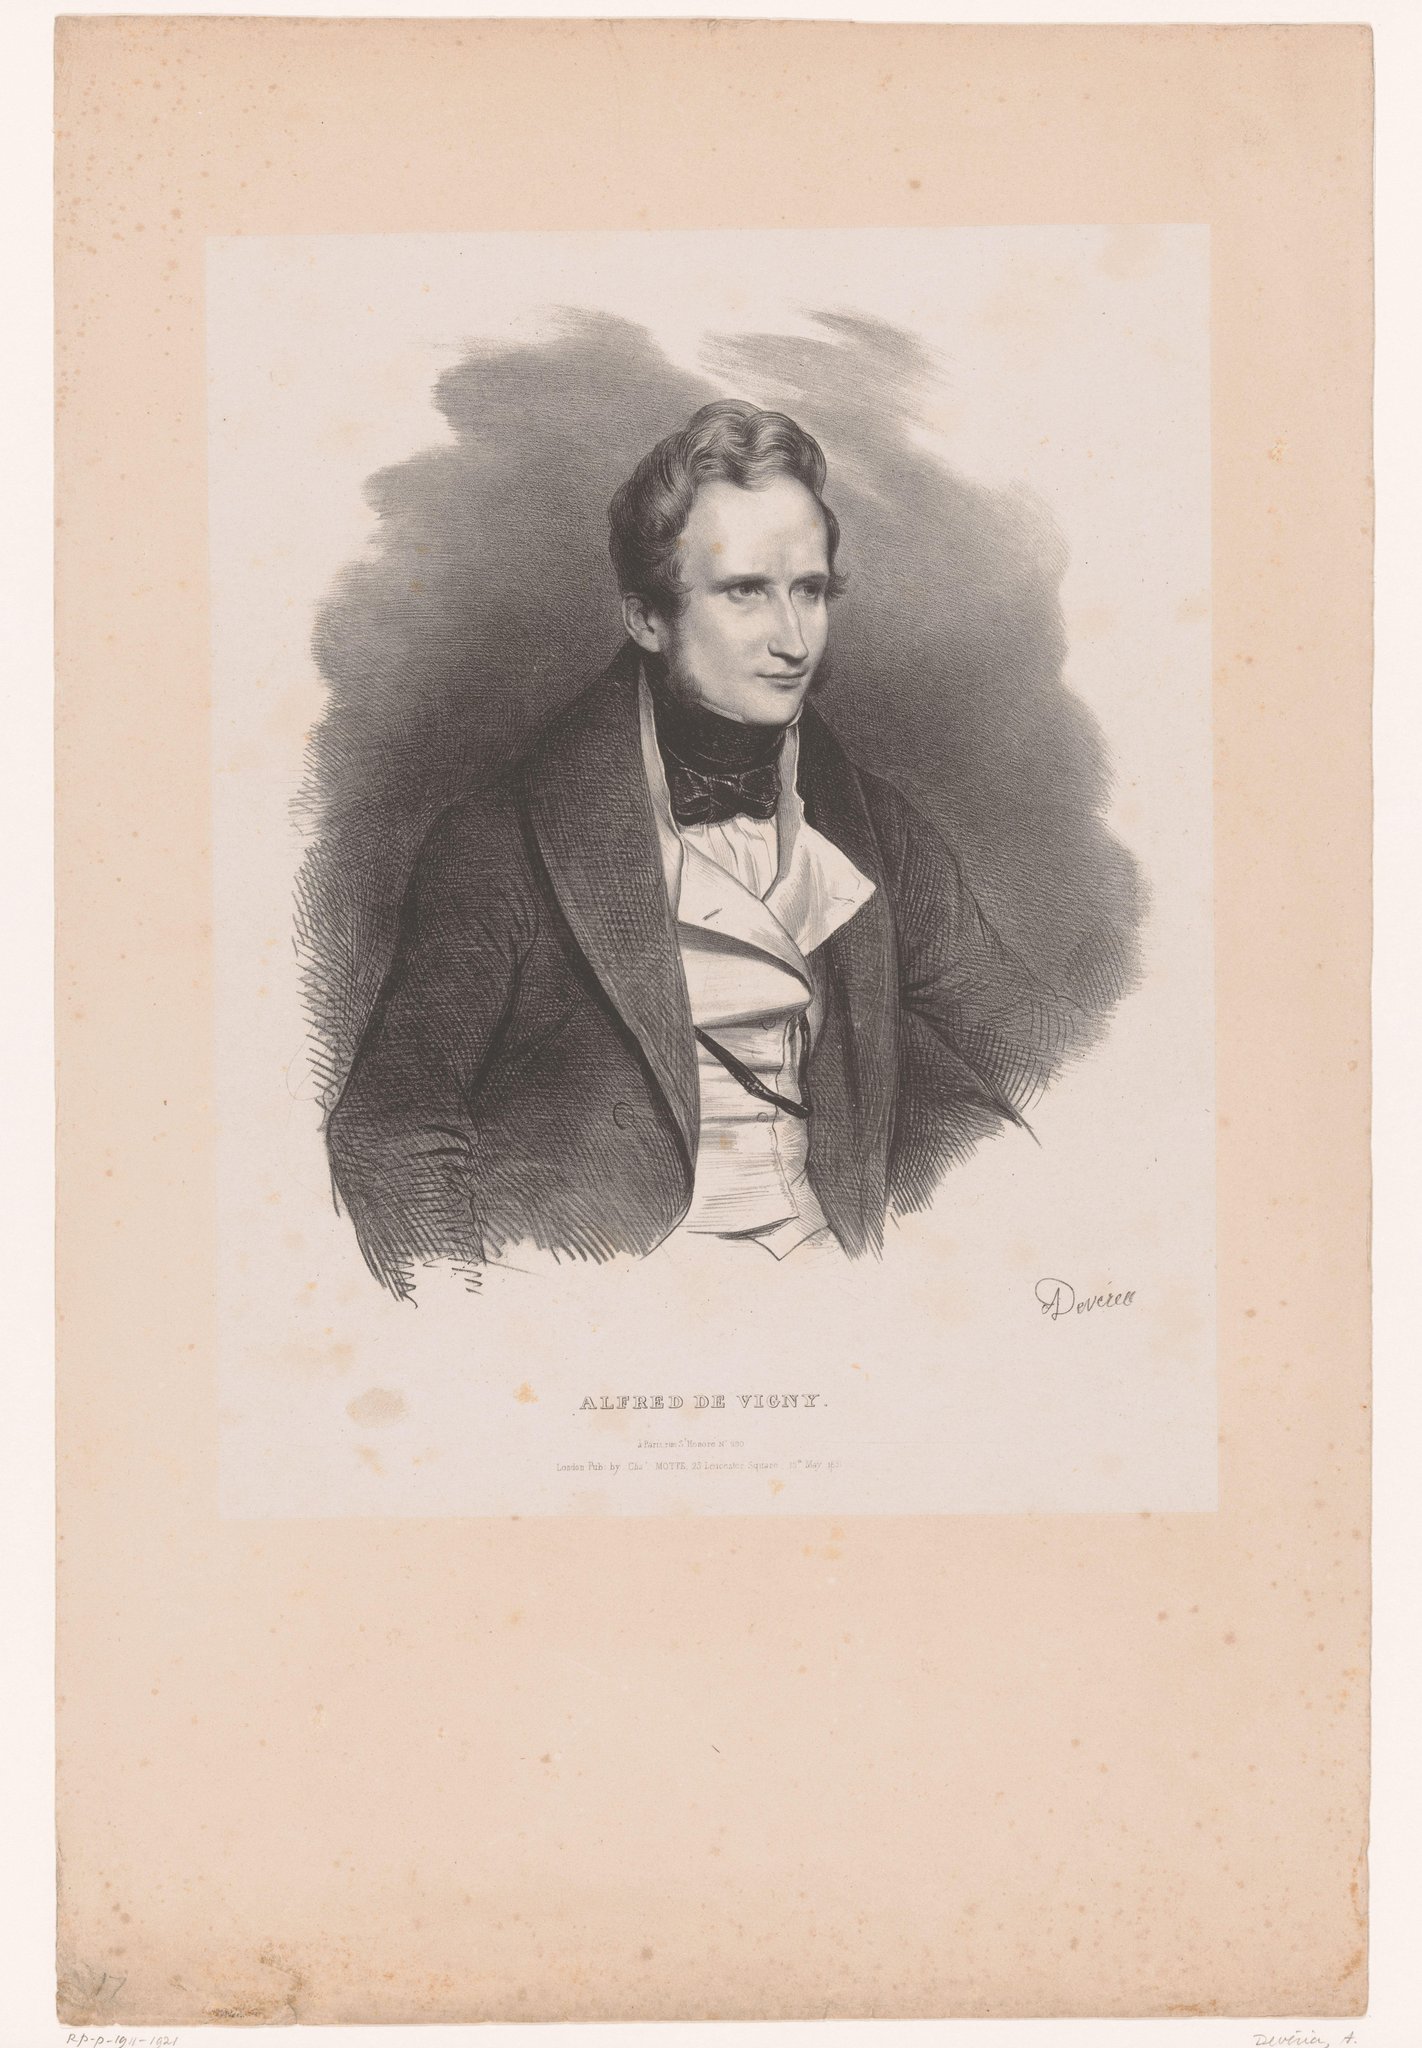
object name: print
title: Portret van Alfred de Vigny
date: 1831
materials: paper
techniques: lithograph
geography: paris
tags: paris, historical persons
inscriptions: collector's mark: Lugt 2228a, check stamp: Lugt 1828c